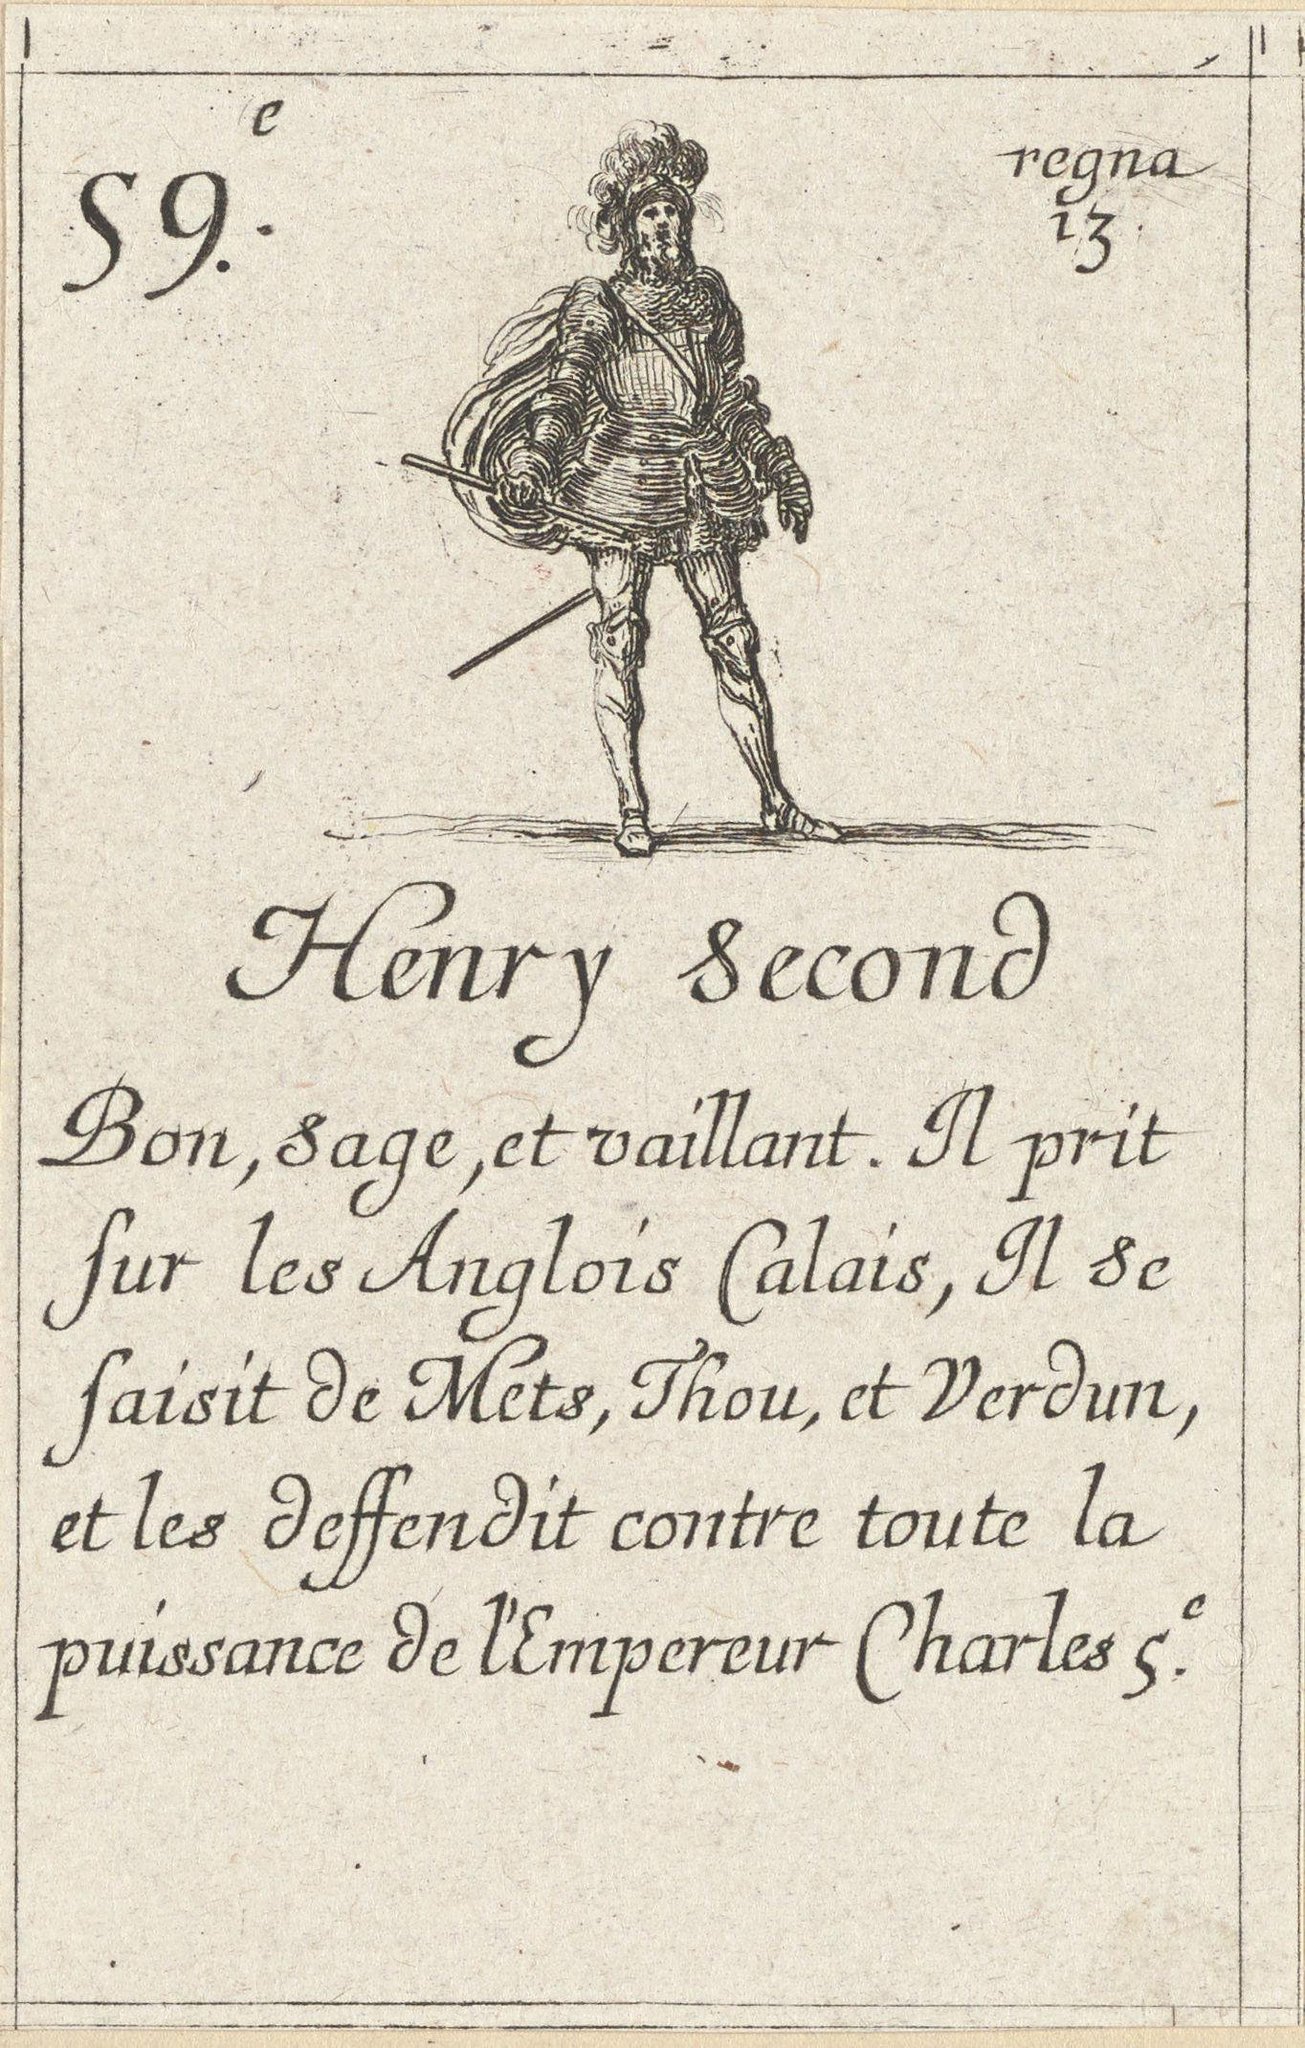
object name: playing card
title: Kaartspel met heersers van Frankrijk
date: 1620-1664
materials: paper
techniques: etching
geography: paris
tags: paris, ruler, sovereign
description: Deze prent maakt deel uit van een kaartspel met 39 kaarten met voorstellingen van Franse koningen. De serie is uitgedacht door Jean Desmarests de Saint-Sorlin in opdracht van Kardinaal Mazarin. Het kaartspel werd gemaakt voor de jonge Lodewijk XIV, samen met het Jeu des Fables, Jeu des Reynes Renommées en Jeu de la géographie.